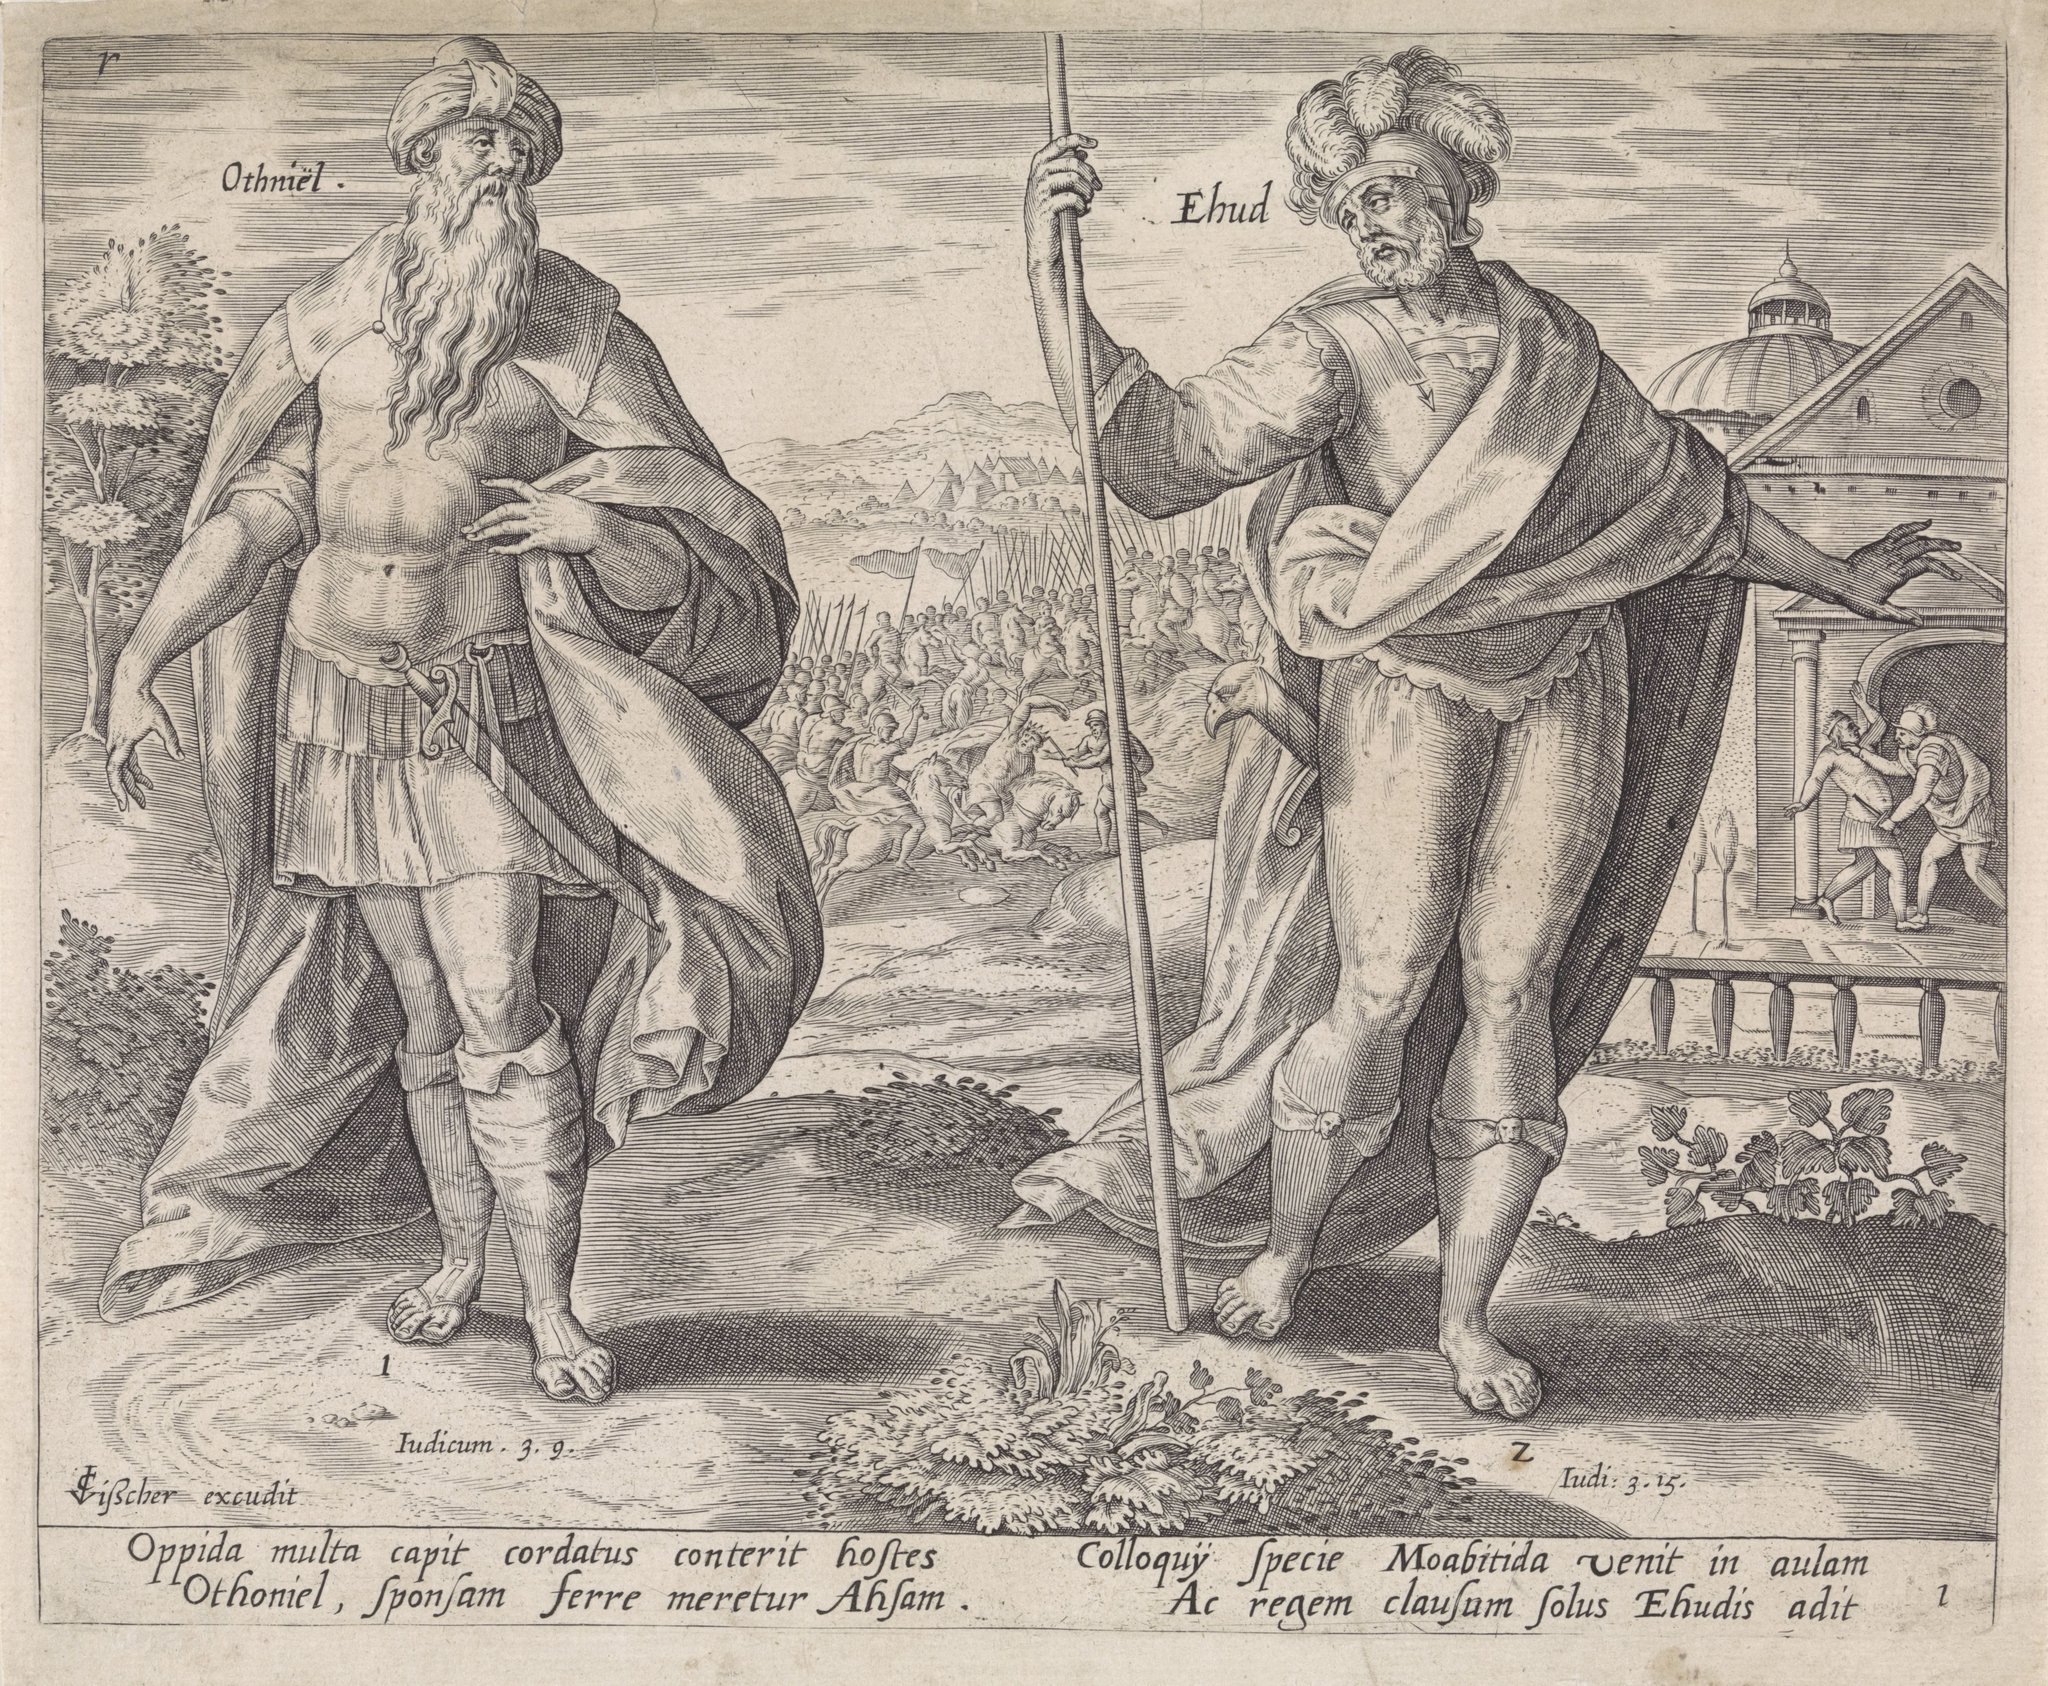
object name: print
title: De twaalf rechters van Israël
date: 1579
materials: paper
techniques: engraving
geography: amsterdam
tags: the left-handed ehud stabs the fat eglon with a dagger in the belly and kills him, othniel conquers debir, and receives caleb's daughter achsah to wife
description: De rechters Otniël en Ehud. Op de achtergrond verovert Otniël de stad Debir. Onder de voorstelling van Otniël een verklarende tekst in het Latijn, waarin staat dat hij voor deze overwinning Achsa als vrouw kreeg. Rechts op de achtergrond doodt Ehud koning Eglon van Moab door hem een zwaard in de buik te steken. Onder de voorstelling van Ehud eveneens een verklarende tekst in het Latijn. Onder de rechters verwijzingen naar de Bijbelteksten in Ri. 3:9 en Ri. 3:15.